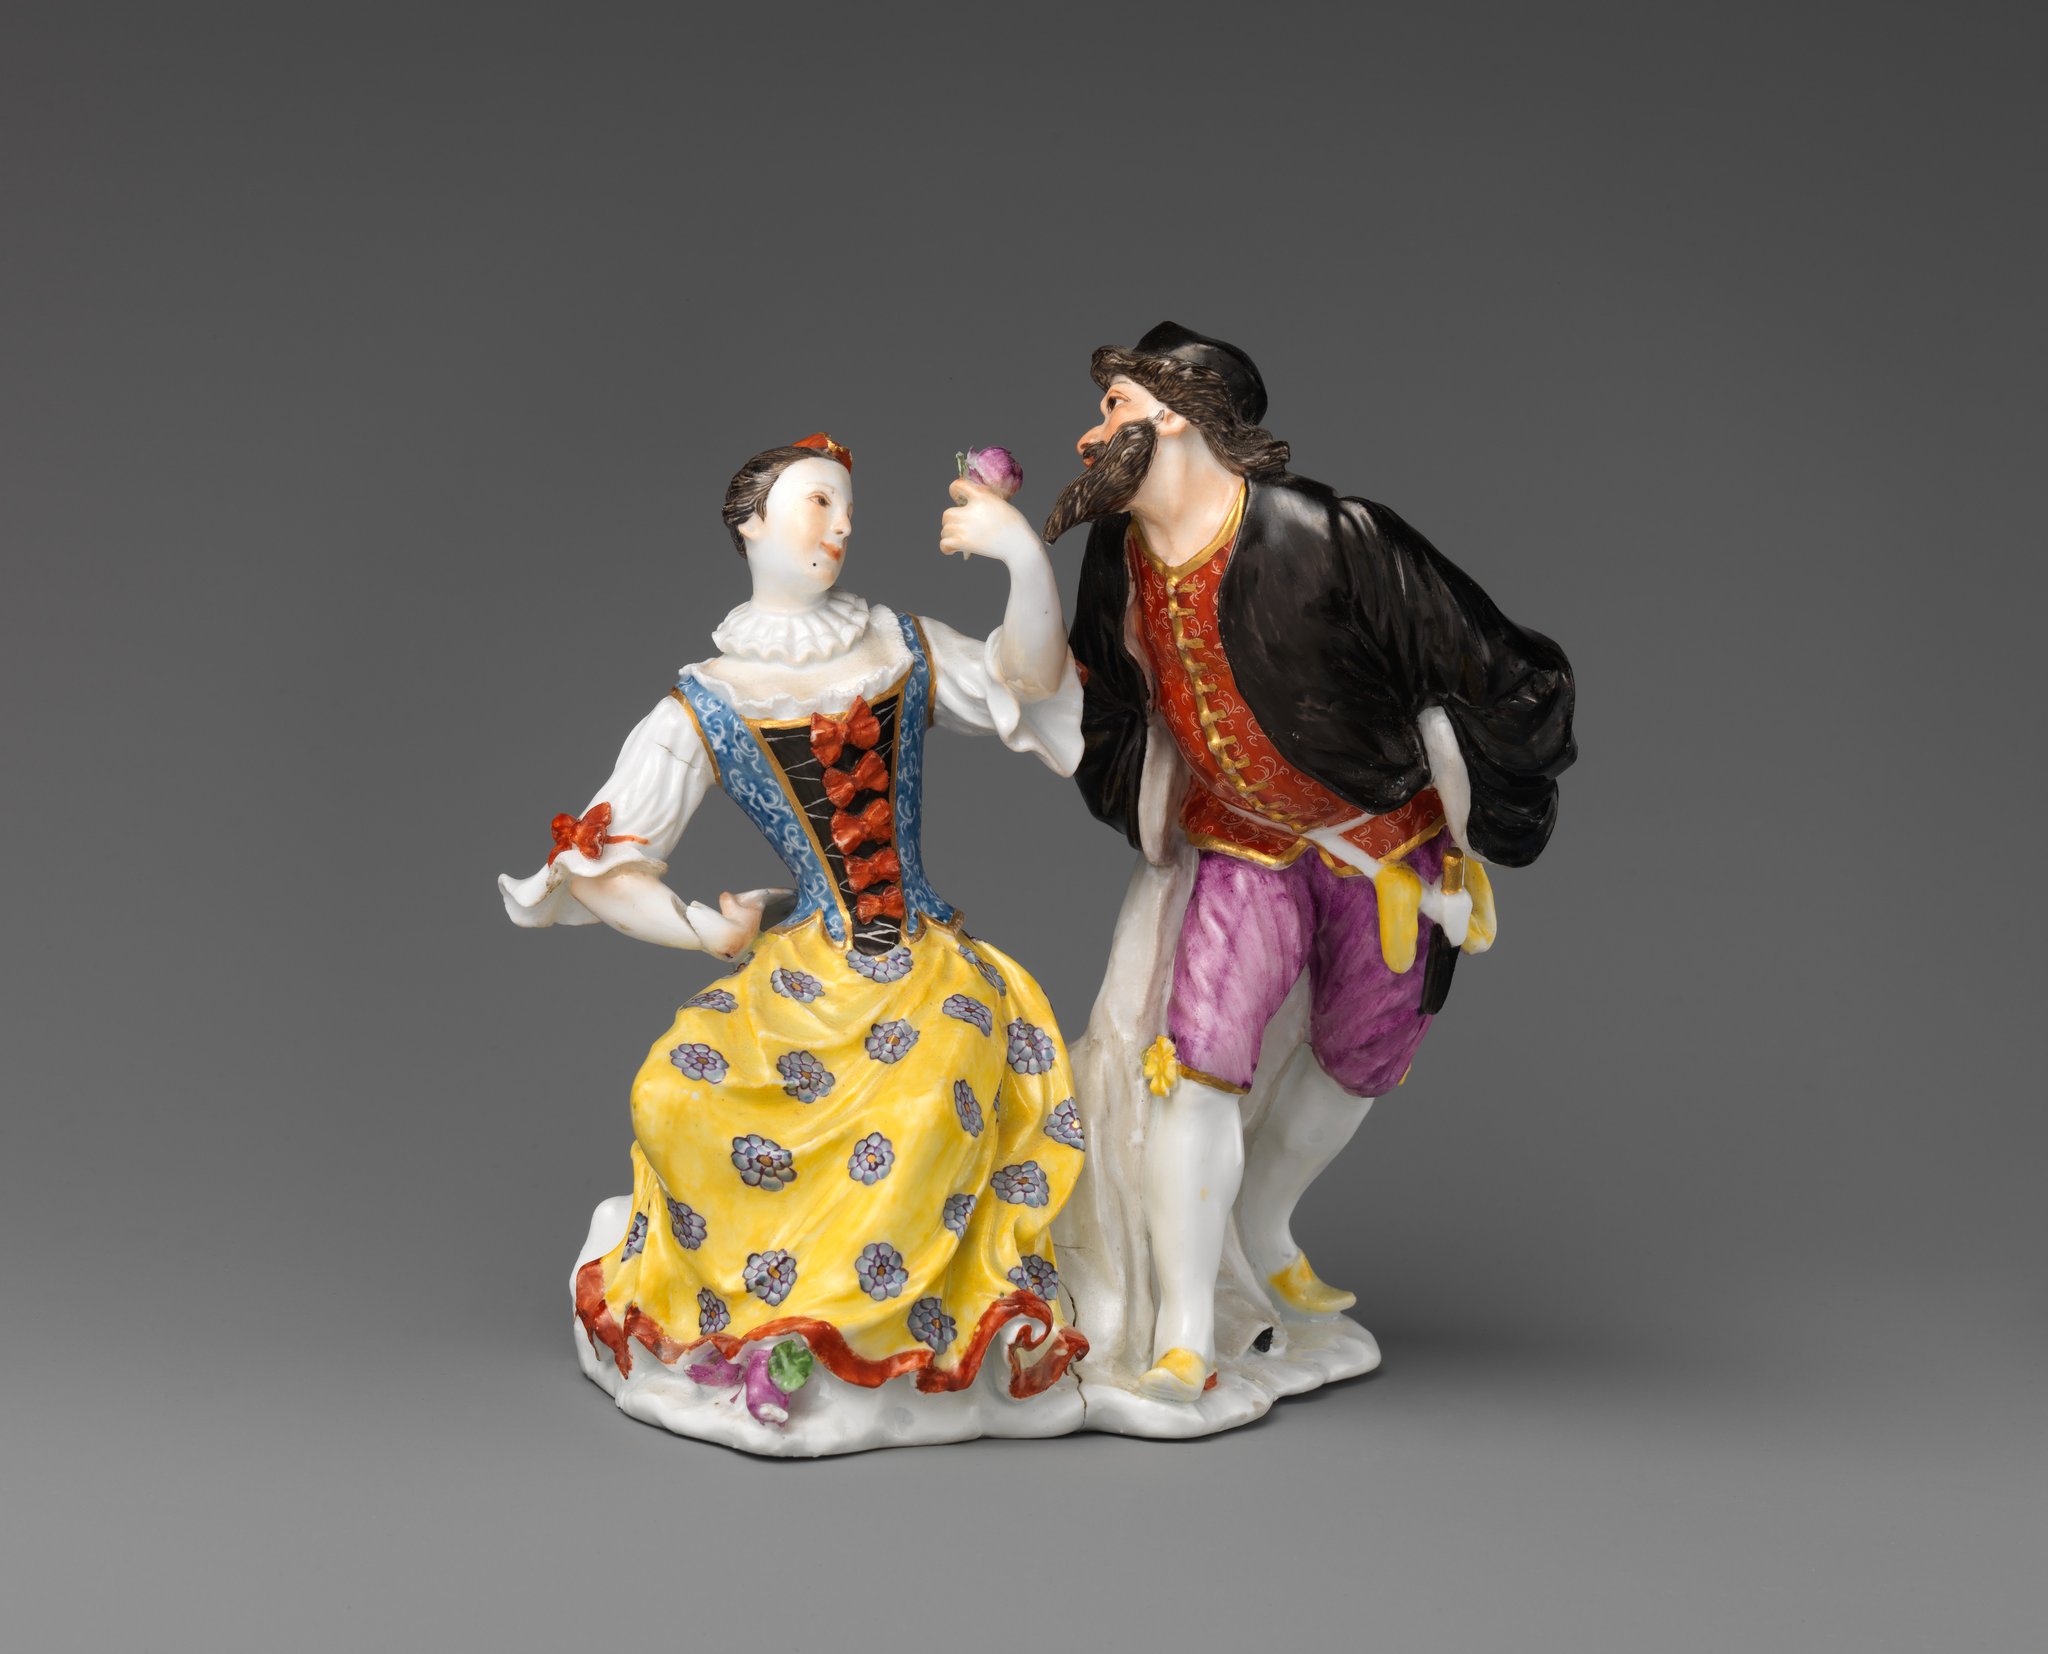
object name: group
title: Columbine and Pantaloon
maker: meissen manufactory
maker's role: manufactory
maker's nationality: german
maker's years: 1710-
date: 1736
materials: hard paste porcelain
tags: men,women,flowers